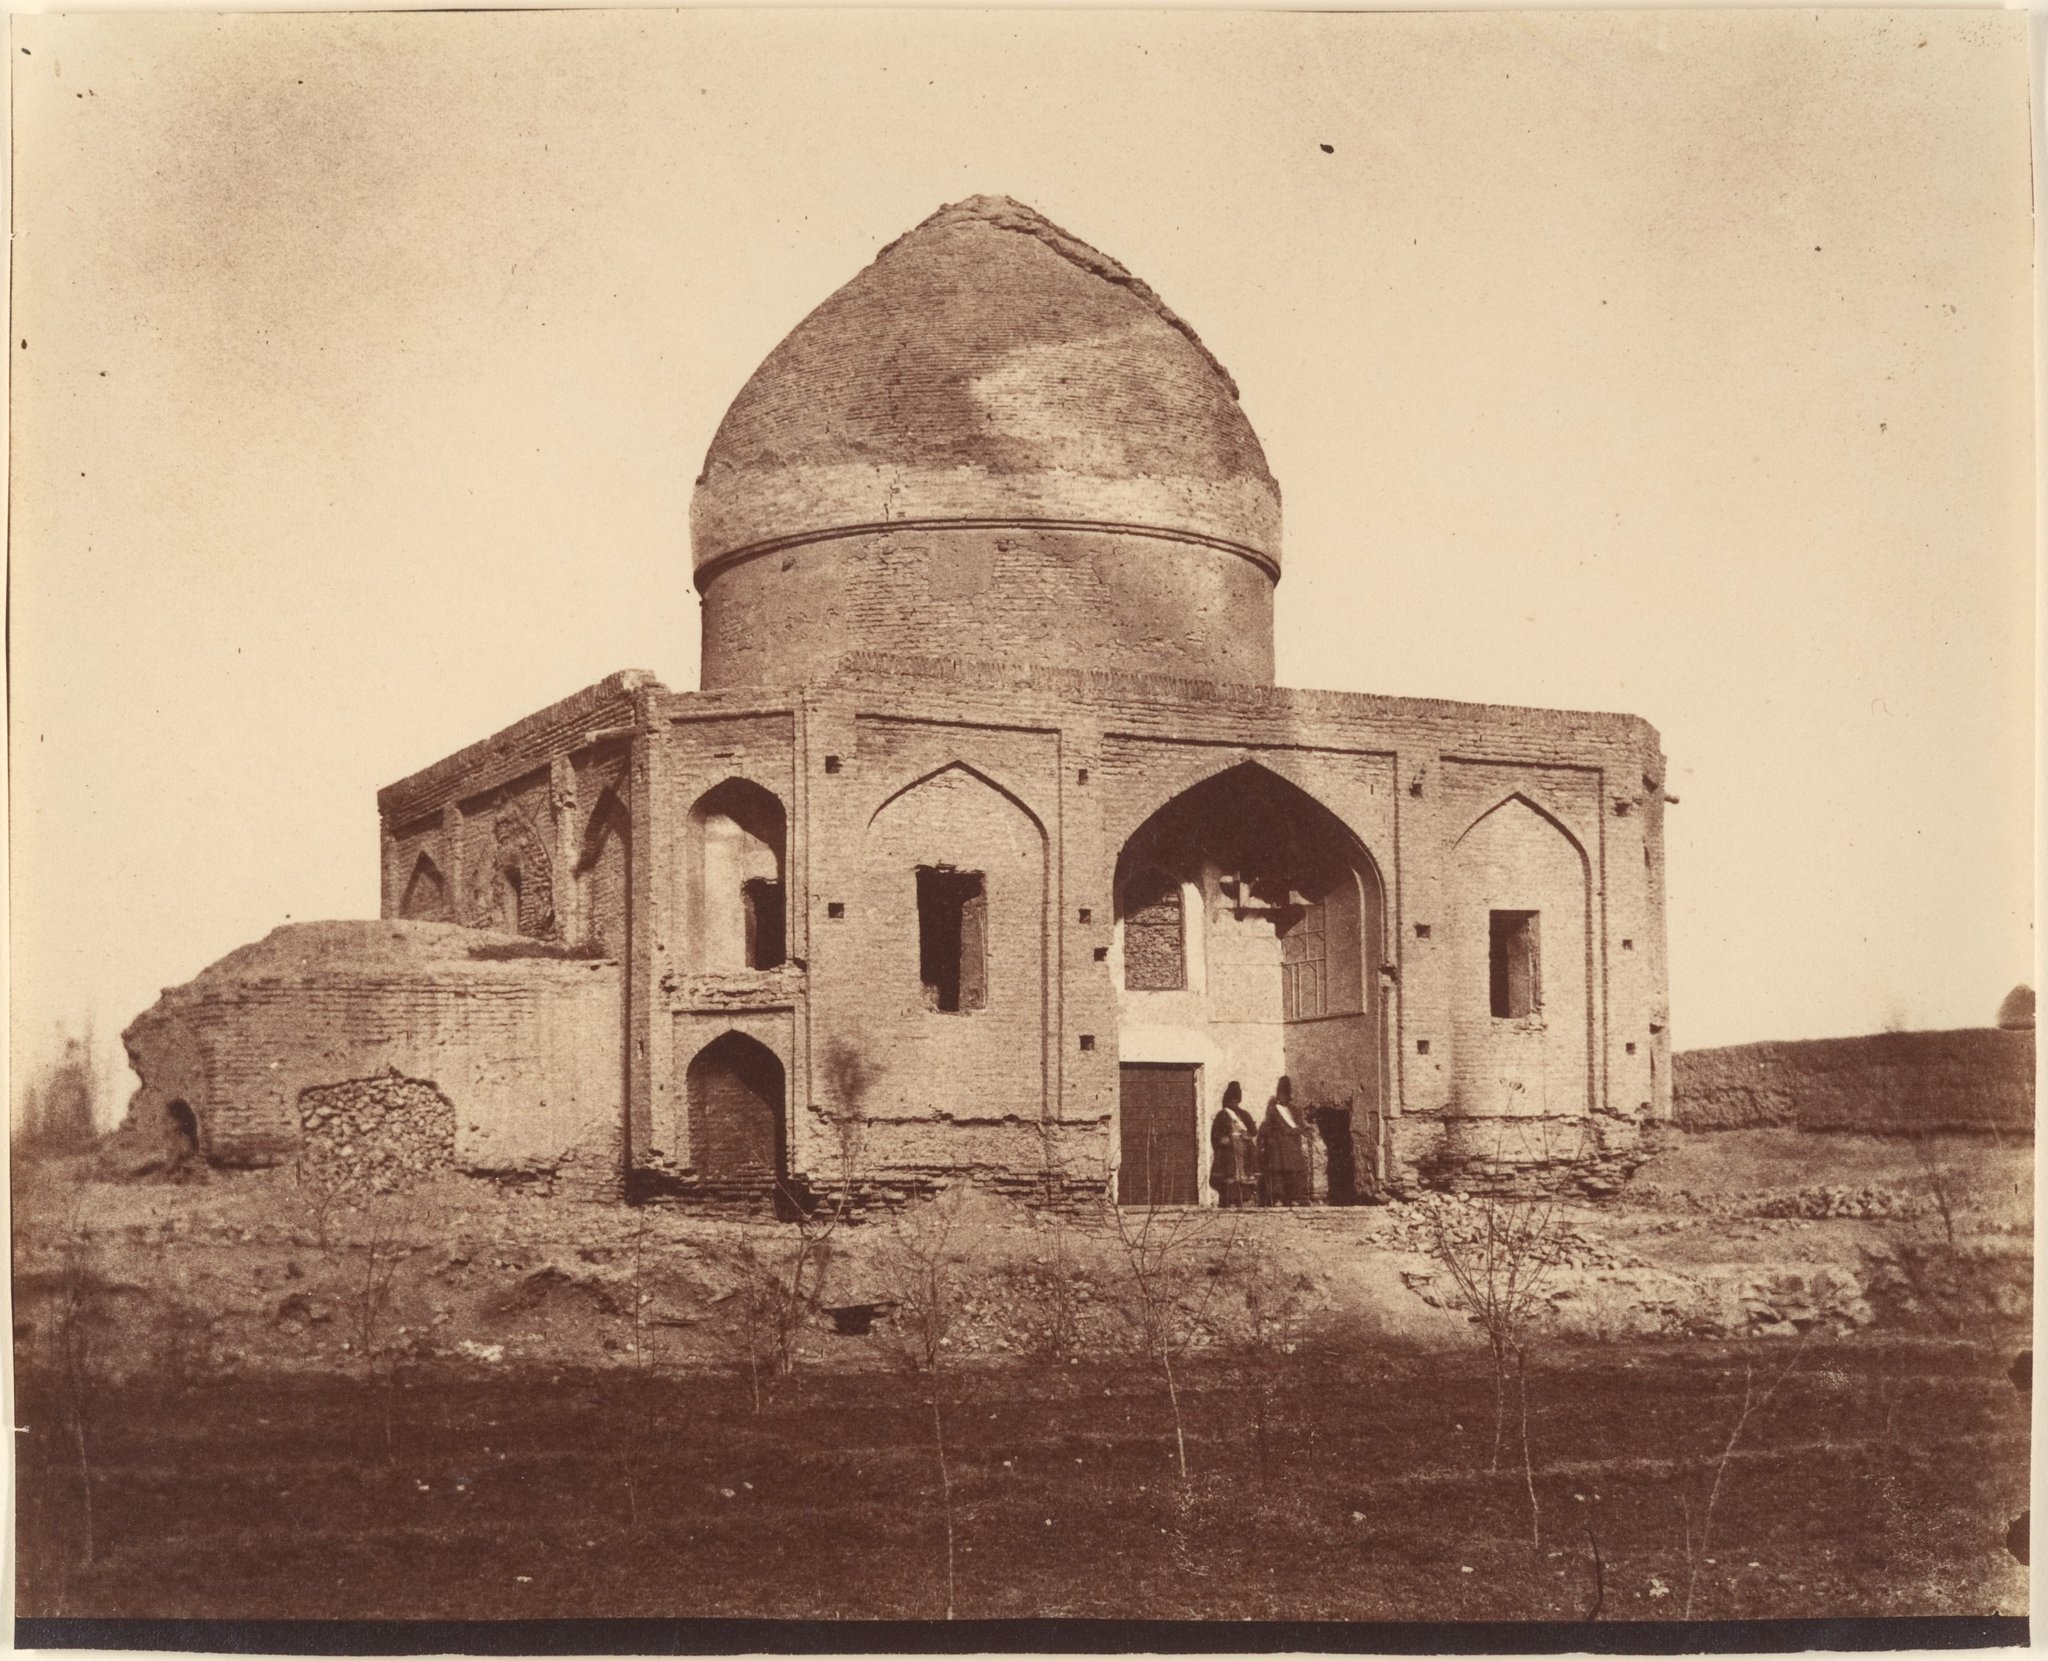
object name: photograph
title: [Tomb of Seeh-i Mumin]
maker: luigi pesce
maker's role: artist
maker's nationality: italian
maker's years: 1818-1891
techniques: albumen silver print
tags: architecture,tombs